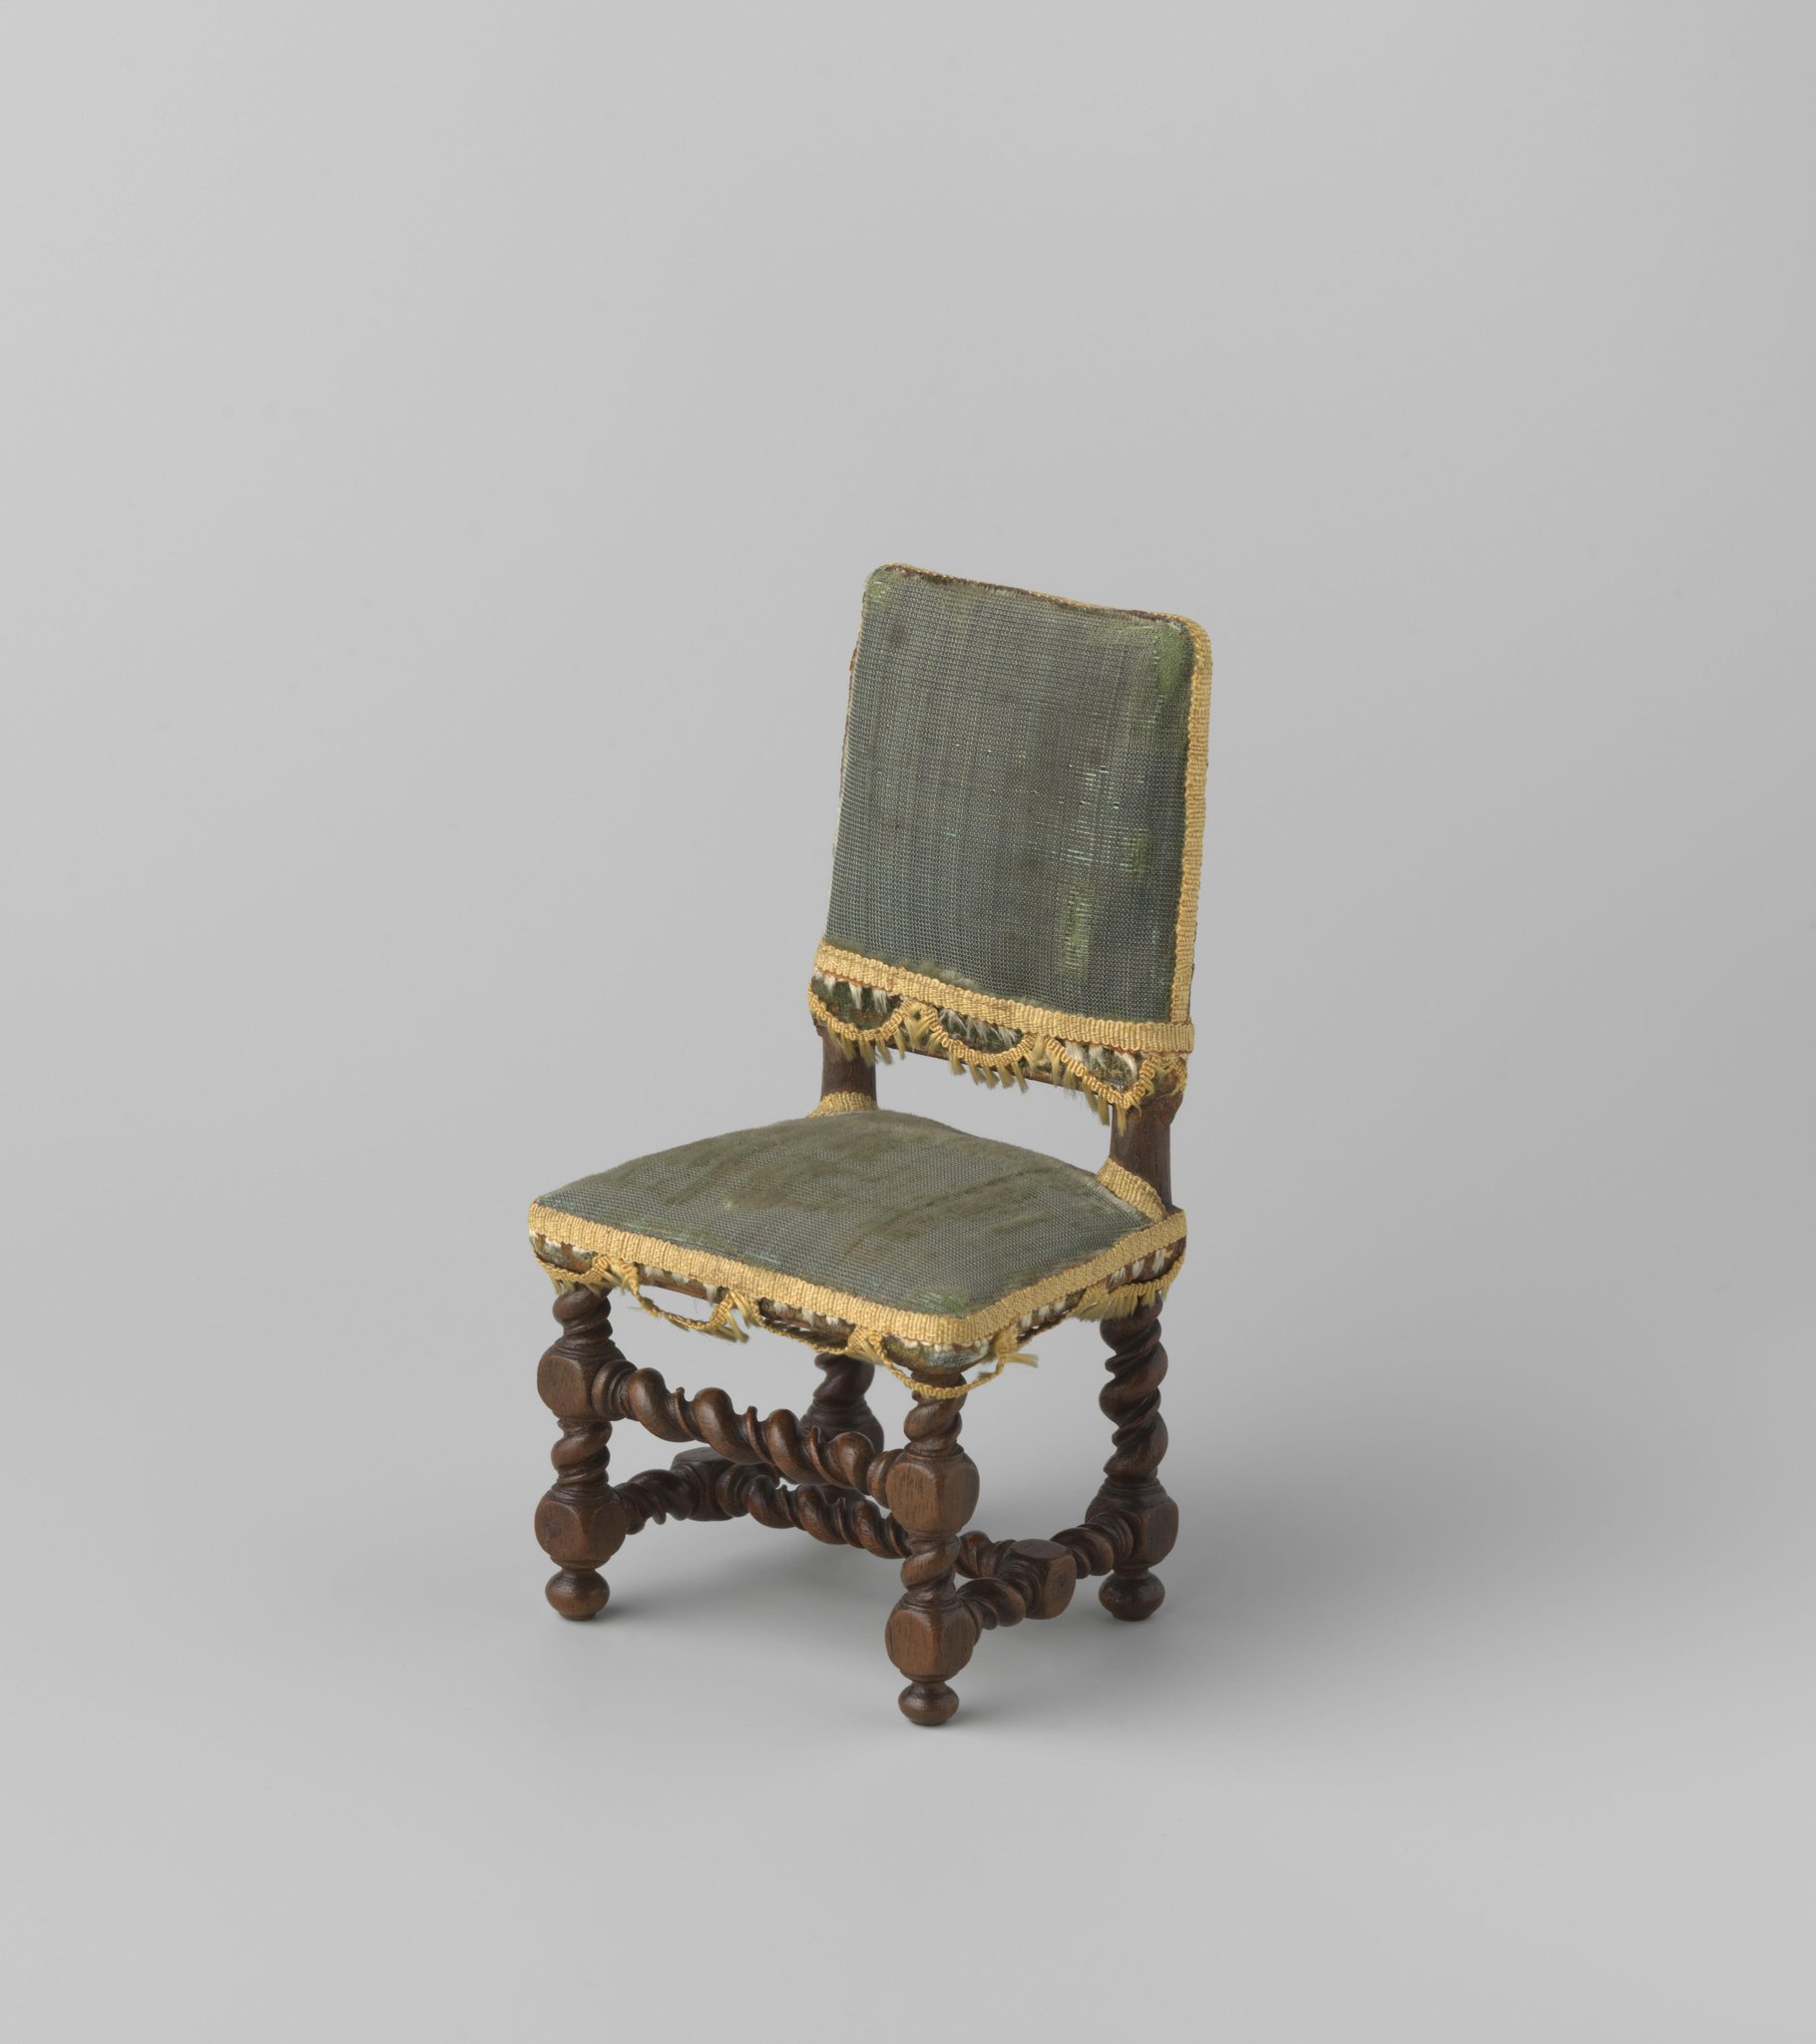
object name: leunstoel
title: Leunstoel vervaardigd van notenhout; stijlen, voorregel en H-vormig kruis met smalle en breede tors versierd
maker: Anonymous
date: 1690-1710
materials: linen, board, silk, wood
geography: amsterdam